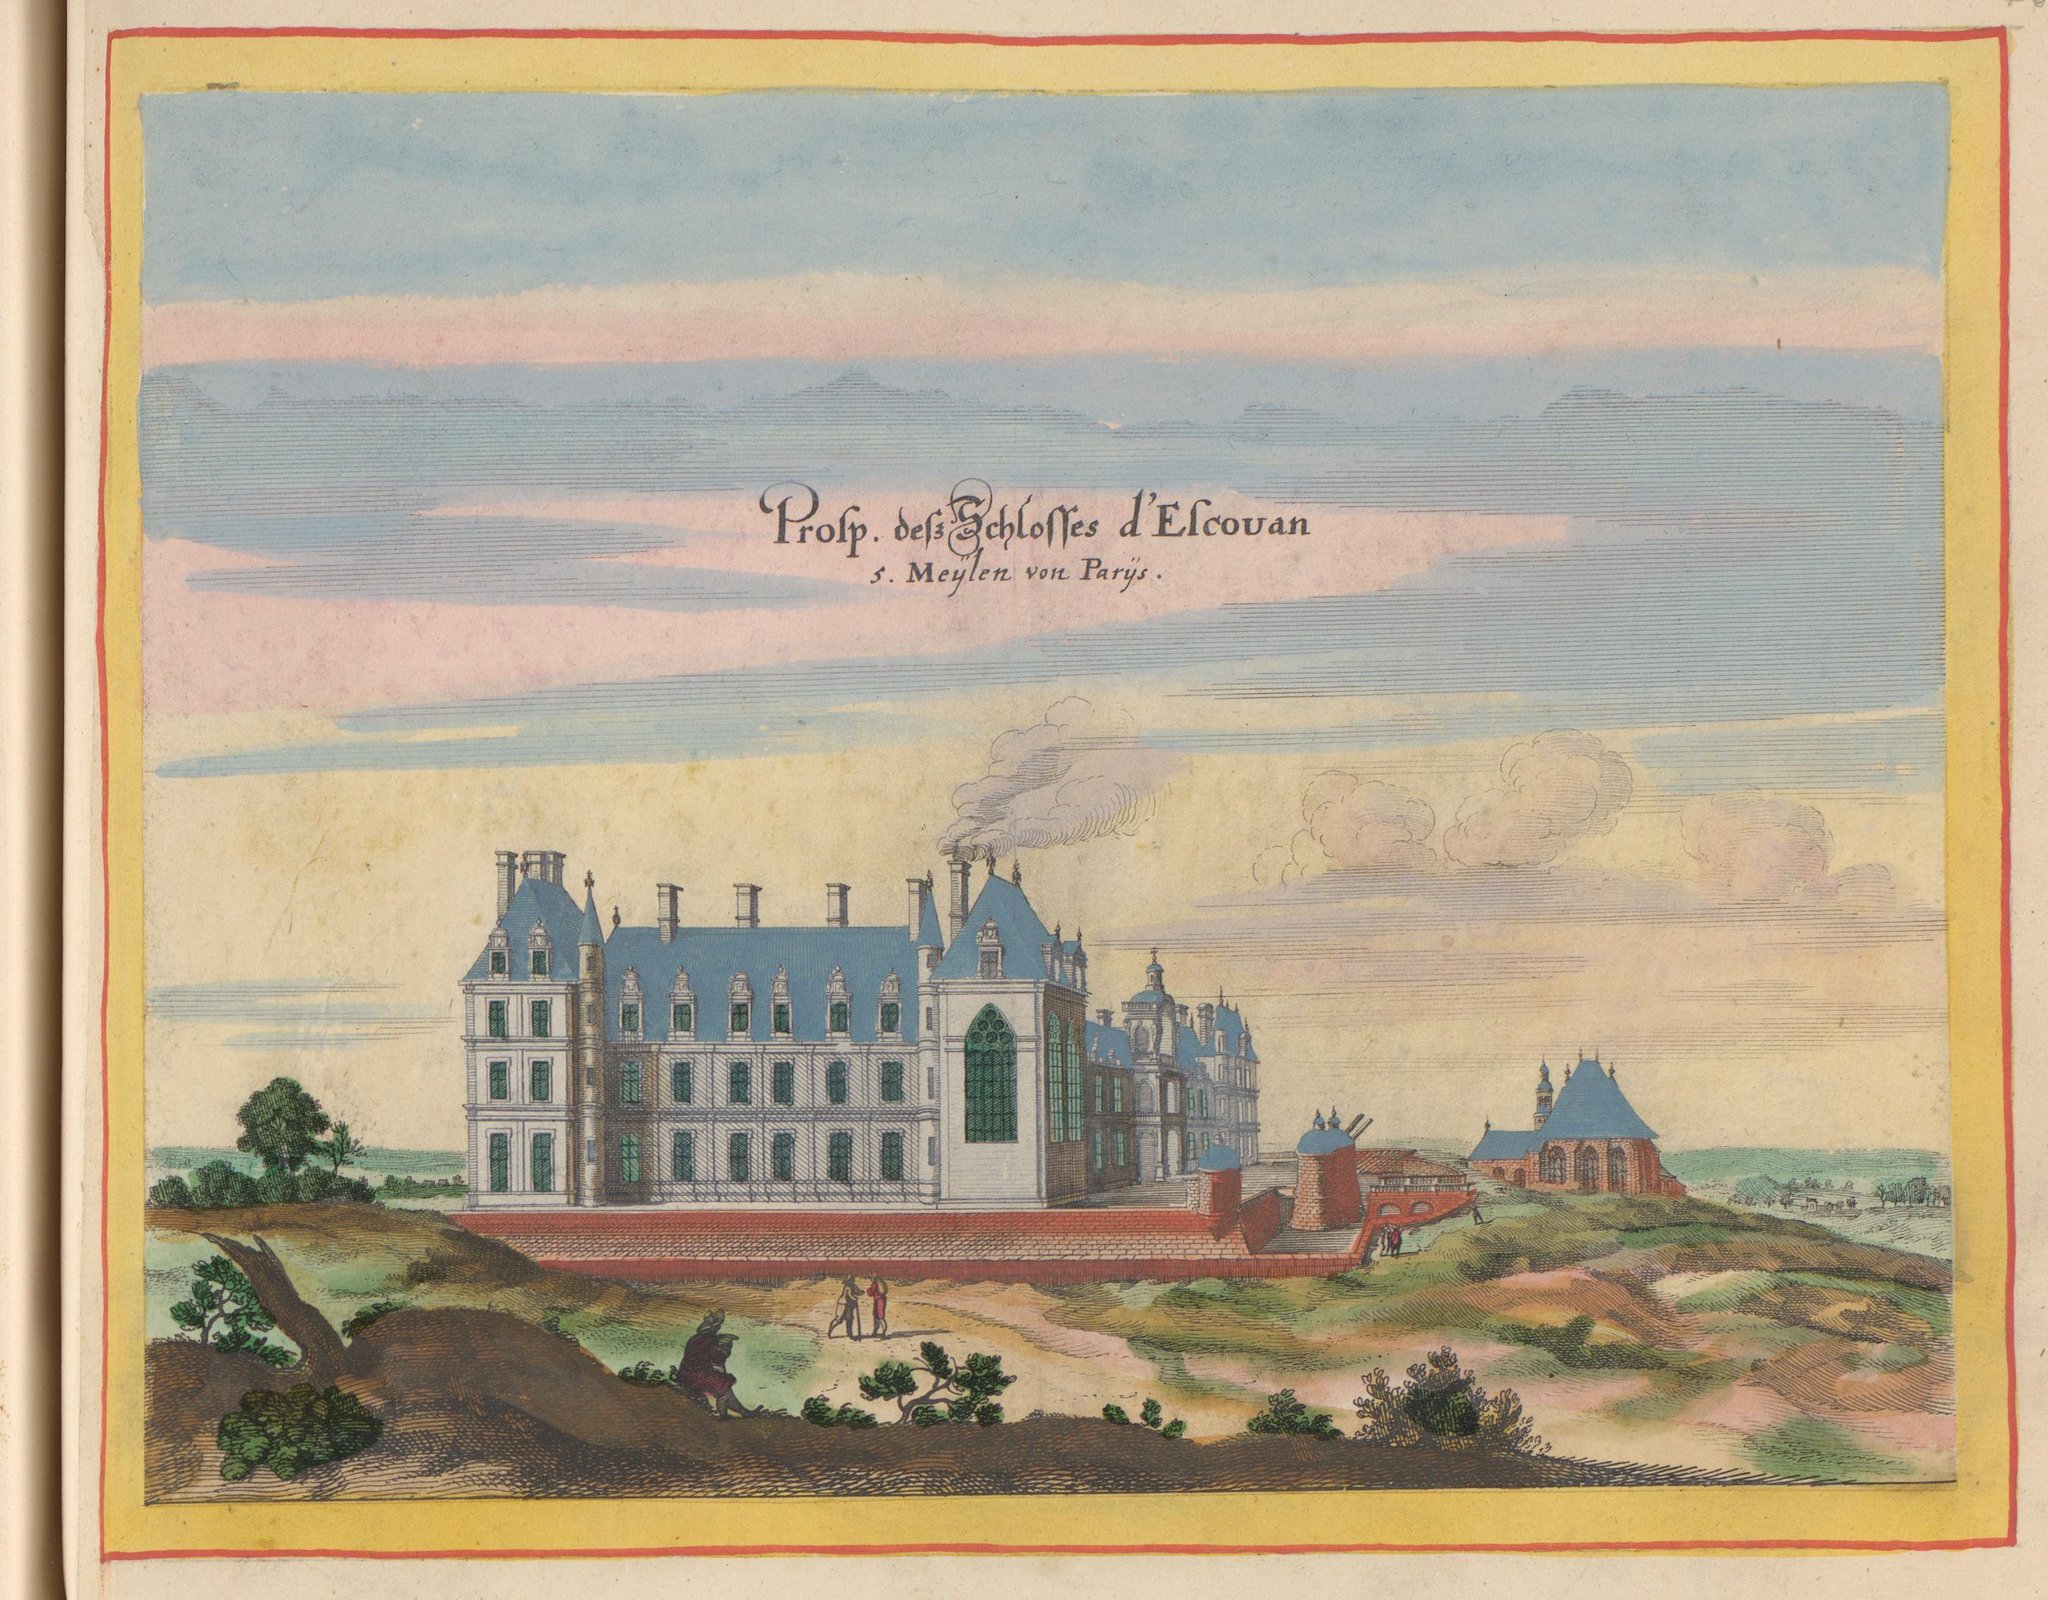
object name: album leaf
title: Prosp. dess Schlosses d'Escouan 5 Meijlen von Parijs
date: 1655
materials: paper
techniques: engraving, etching, hand coloring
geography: the hague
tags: castle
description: Prent origineel vervaardigd als boekillustratie voor: Zeiller, Martin. Topographia Galliae, oder Beschreibung und Contrafaitung der vornehmbsten und bekantisten Oerter in dem mächtigen und grossen Königreich Frankreich, 13 delen. Frankfurt am Main: Caspar Merian, 1655-1661. De prent werd voor het eerst gepubliceerd in deel 1: Topographia Galliae, 1655. De prent is langs de bovenrand van de voorstelling afgescheurd. De voorstelling is aan de bovenzijde aangevuld met een geschilderde lucht.